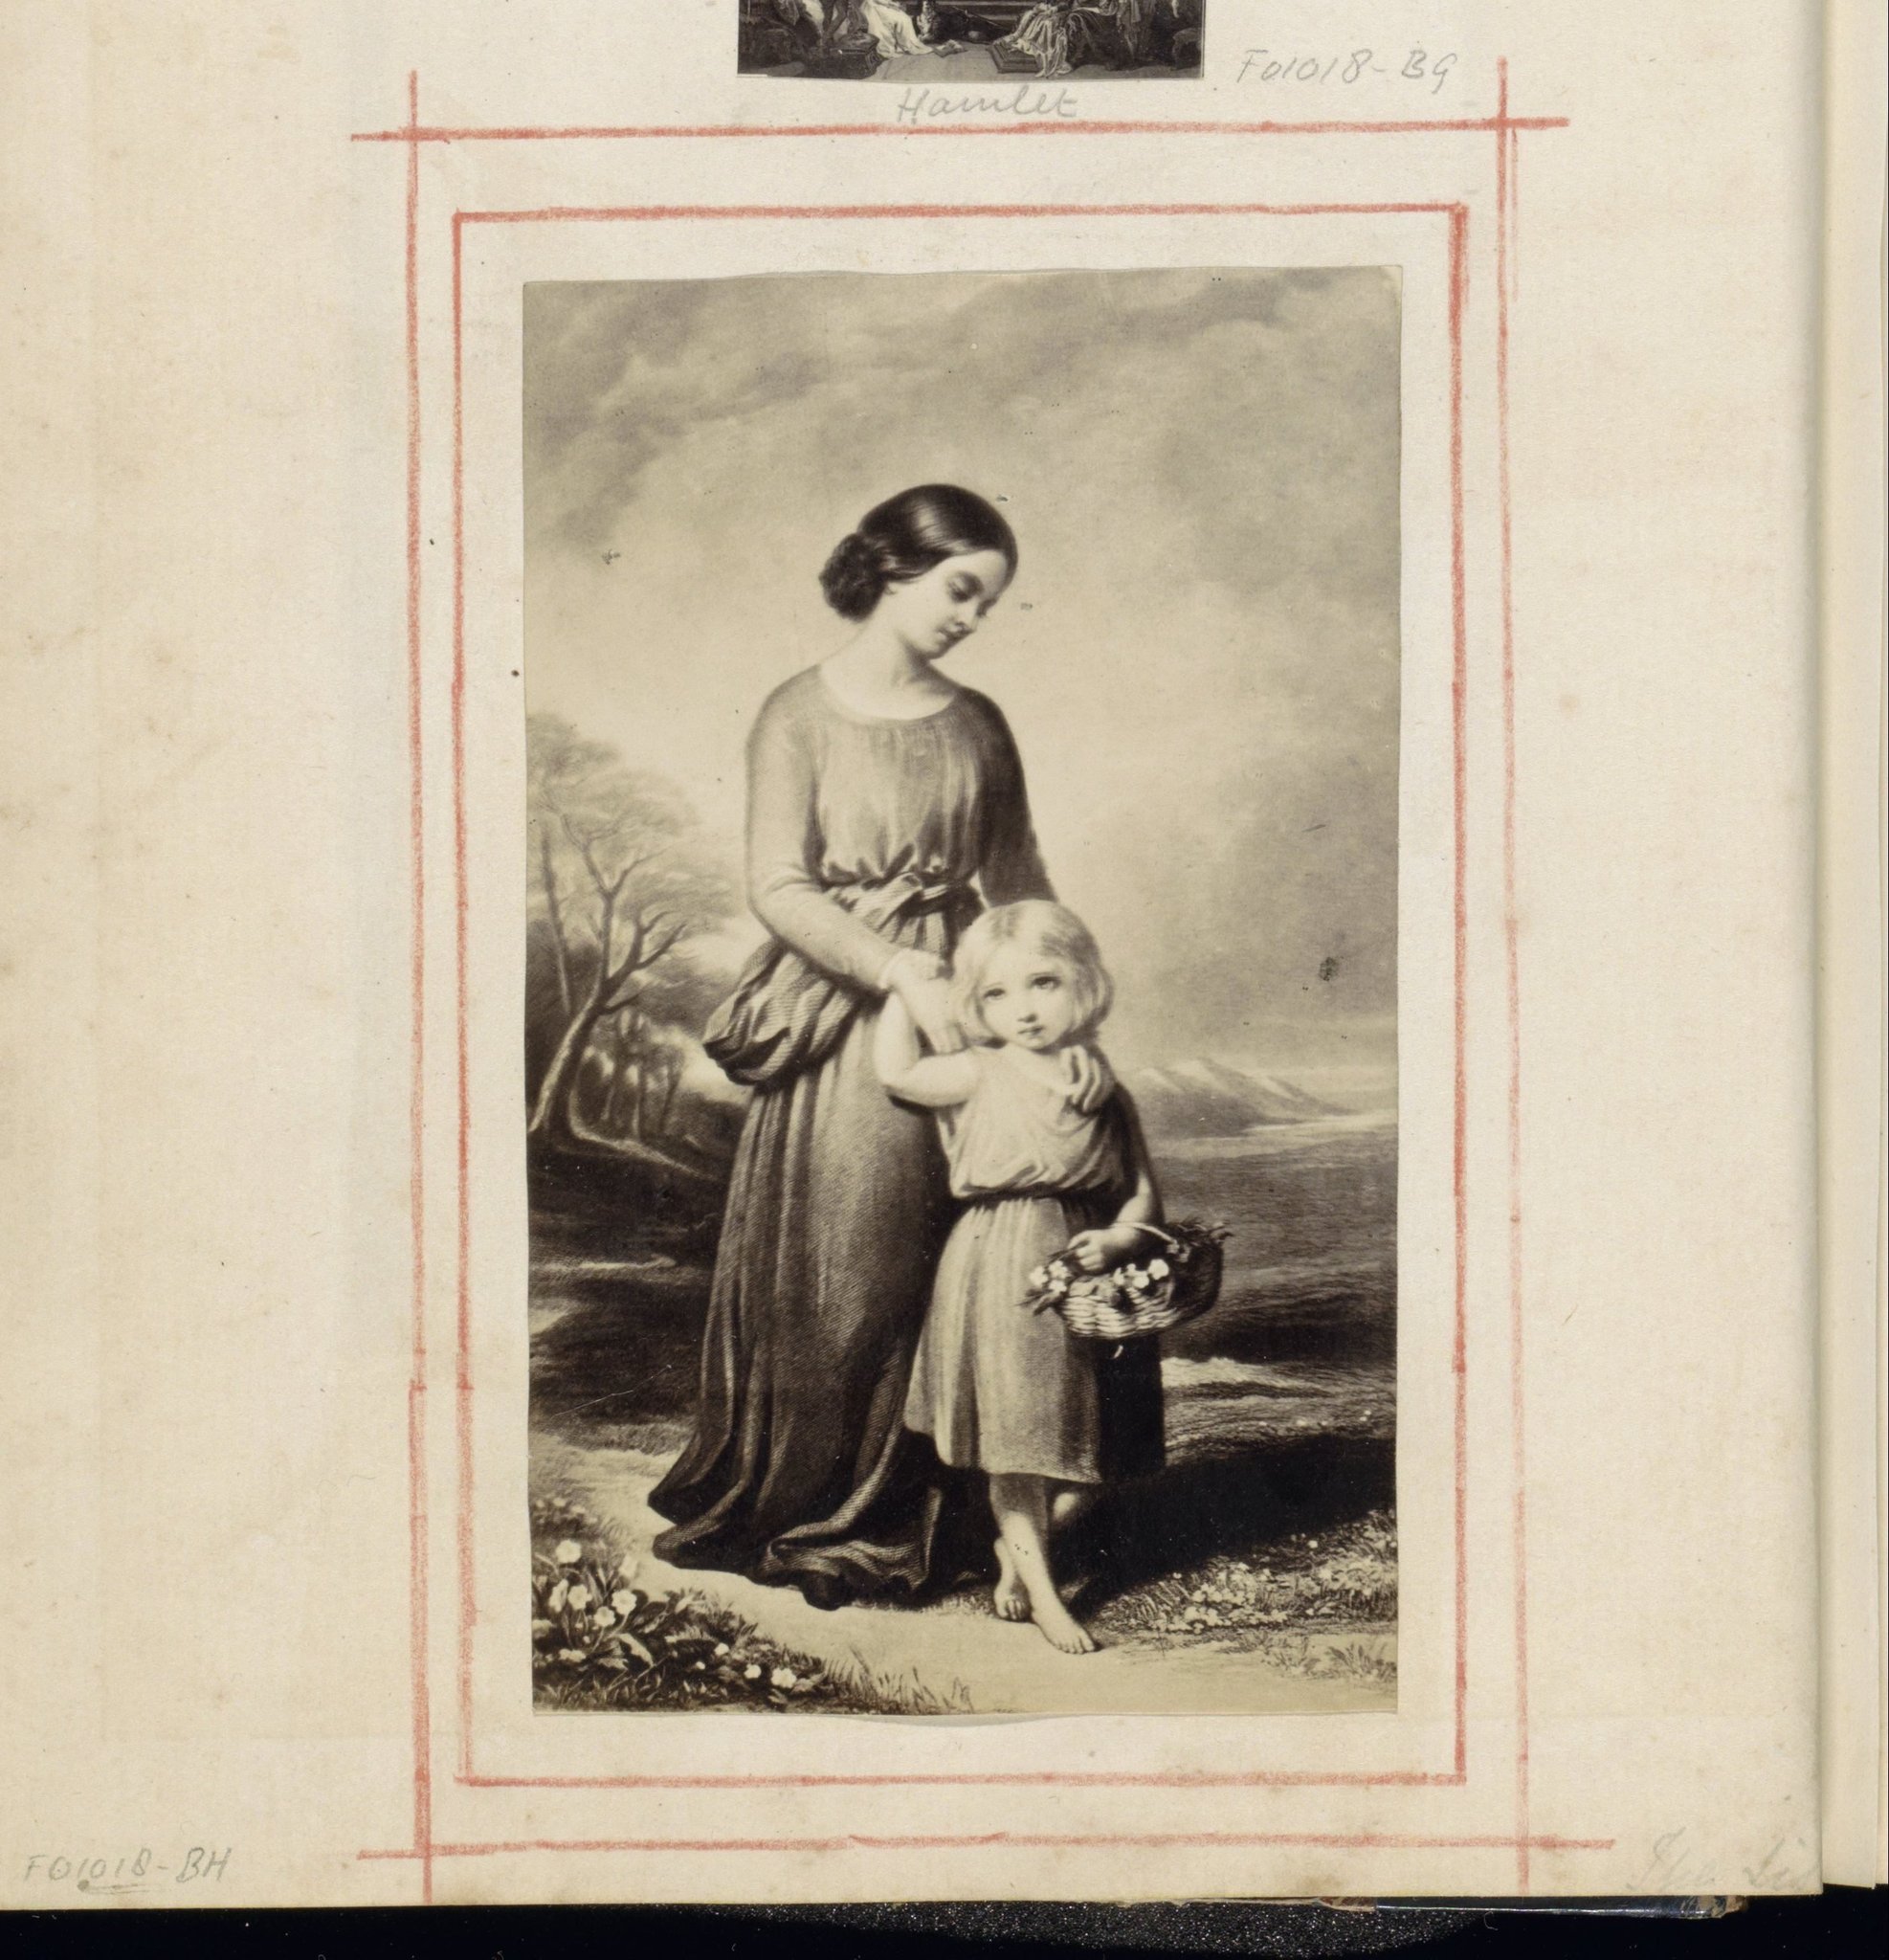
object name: reproduction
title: Fotoreproductie van (vermoedelijk) een schilderij van twee zussen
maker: Anonymous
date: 1860-1870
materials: paper, photographic support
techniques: albumen print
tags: brothers or sisters (second degree family relationships)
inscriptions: inscription: ‘The Sisters’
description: Onderdeel van Engels familiealbum met foto's van personen, reizen, cricket en kunstwerken.